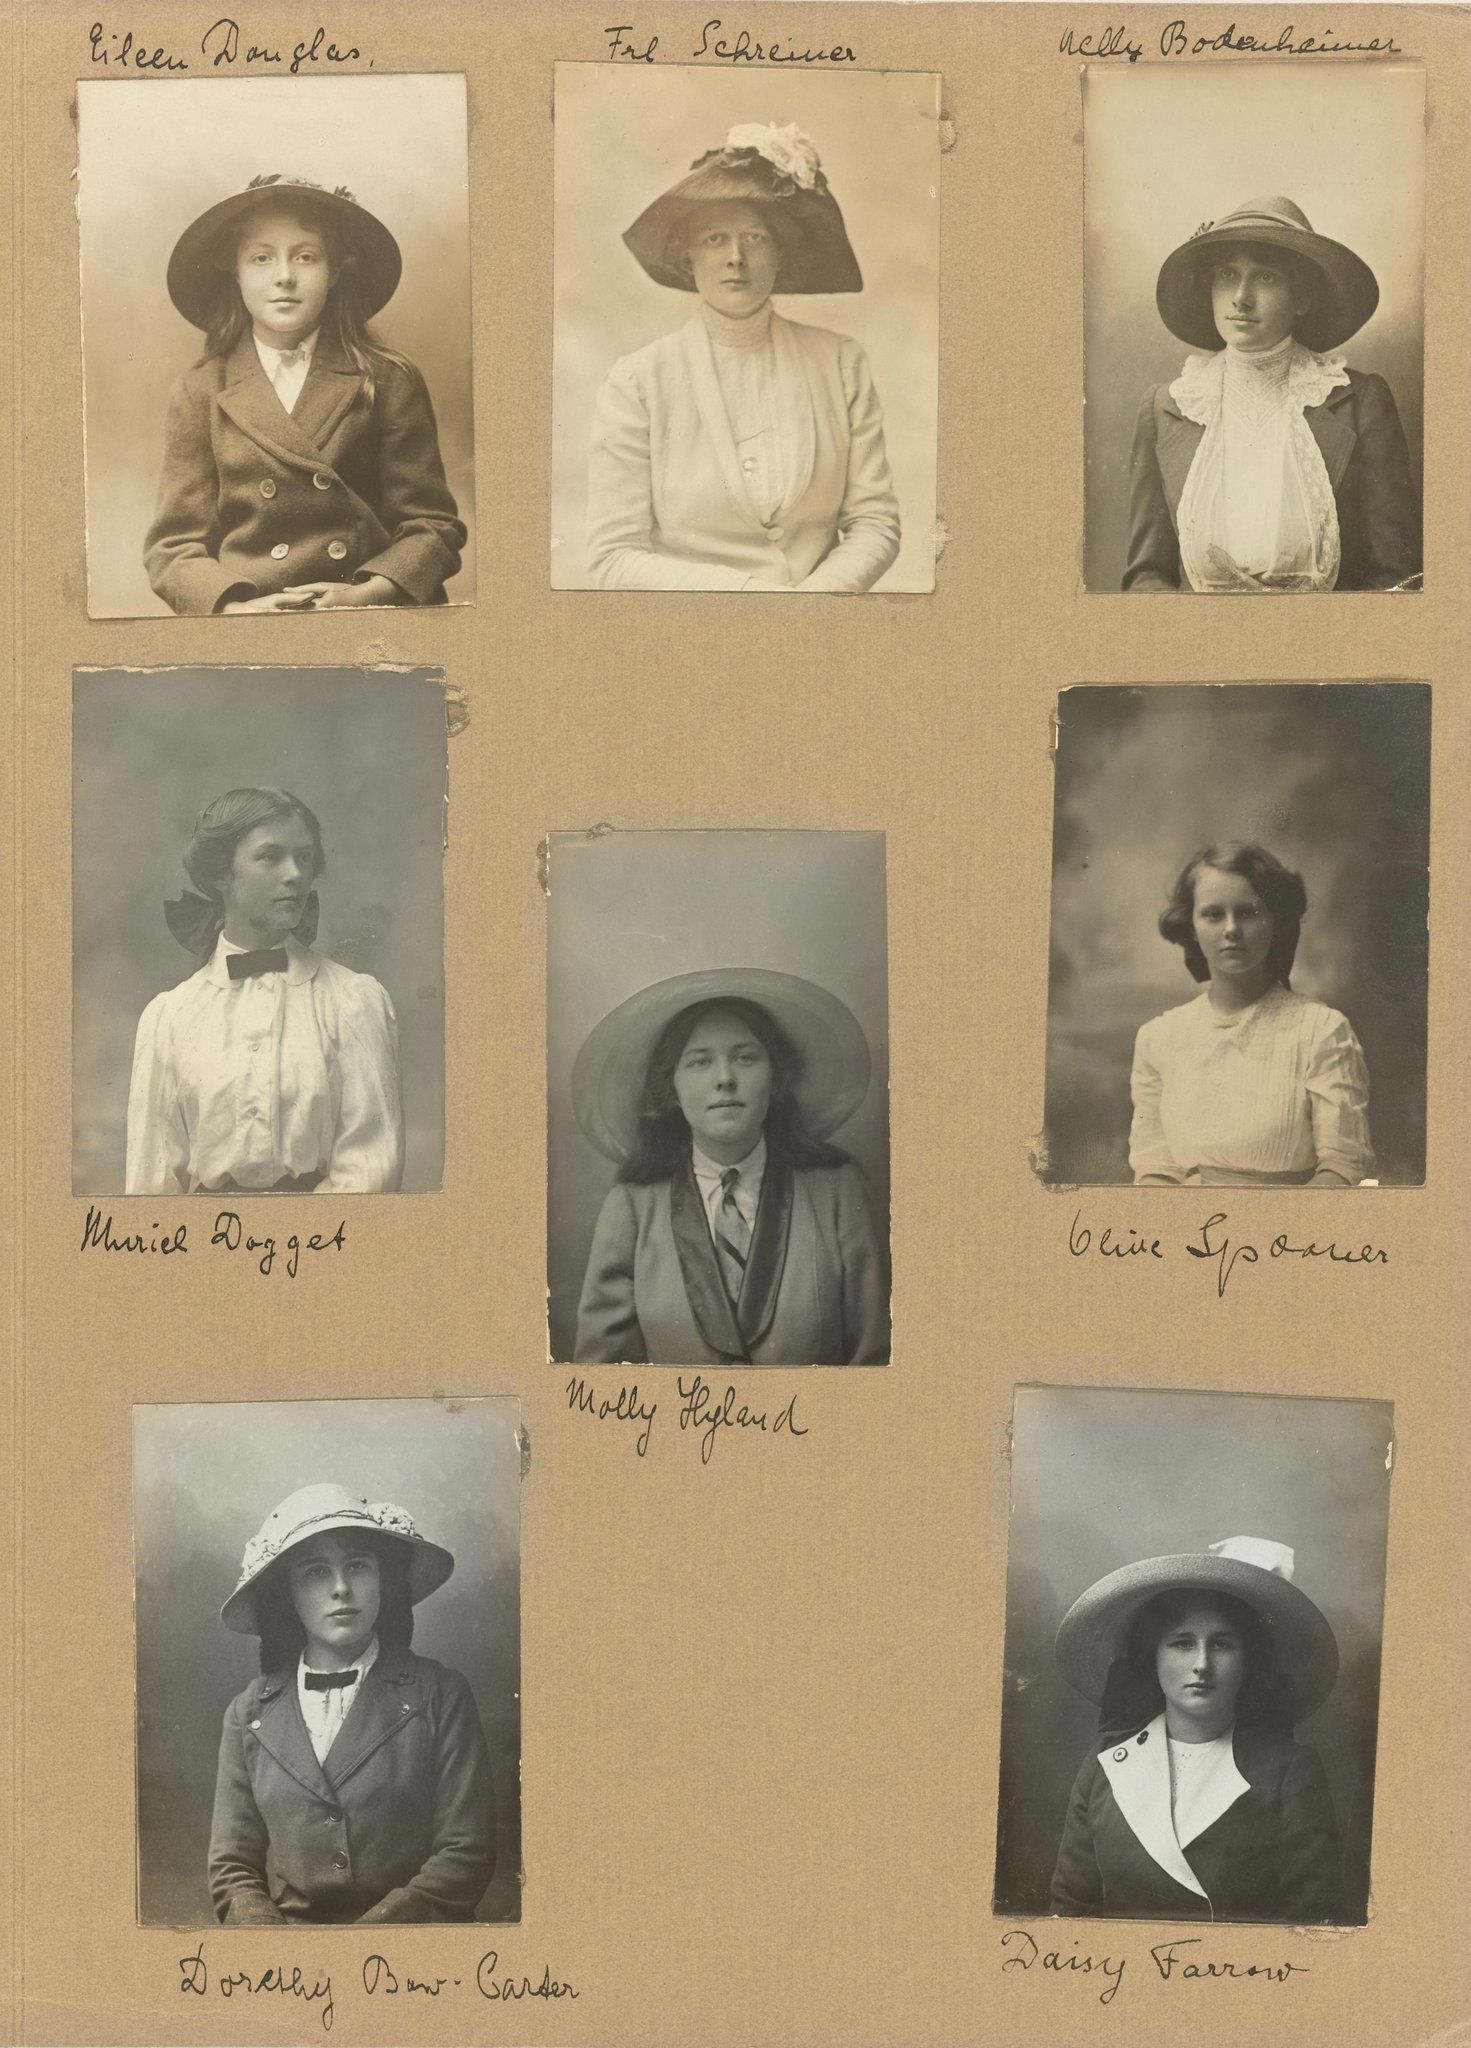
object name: photograph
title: Kartonnen vel met de portretten van Eileen Douglas, Fraulein Schreiner, Nelly Bodenheimer, Muriel Dogget, Molly Hyland, Eline Spooner, Dorothy Bow-Carter en Daisy Farrow, Bexhill-on-Sea in Engeland, 1913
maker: Anonymous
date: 1913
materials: photographic support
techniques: gelatin silver print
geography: bexhill-on-sea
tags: england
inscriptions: name: ‘Eileen Douglas Frl. Schreiner Nelly Bodenheimer Muriel Dogget Molly Hyland Eline Spooner Doroty Bow-Carter Daisy Farrow’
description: Kartonnen vel met de portretten van Eileen Douglas (boven, links), Fraulein Schreiner (boven, midden), Nelly Bodenheimer (boven, rechts), Muriel Dogget (midden, links), Molly Hyland (midden, central), Eline Spooner (midden, rechts), Dorothy Bow-Carter (onder, links) en Daisy Farrow (onder, rechts), Bexhill-on-Sea in Engeland.